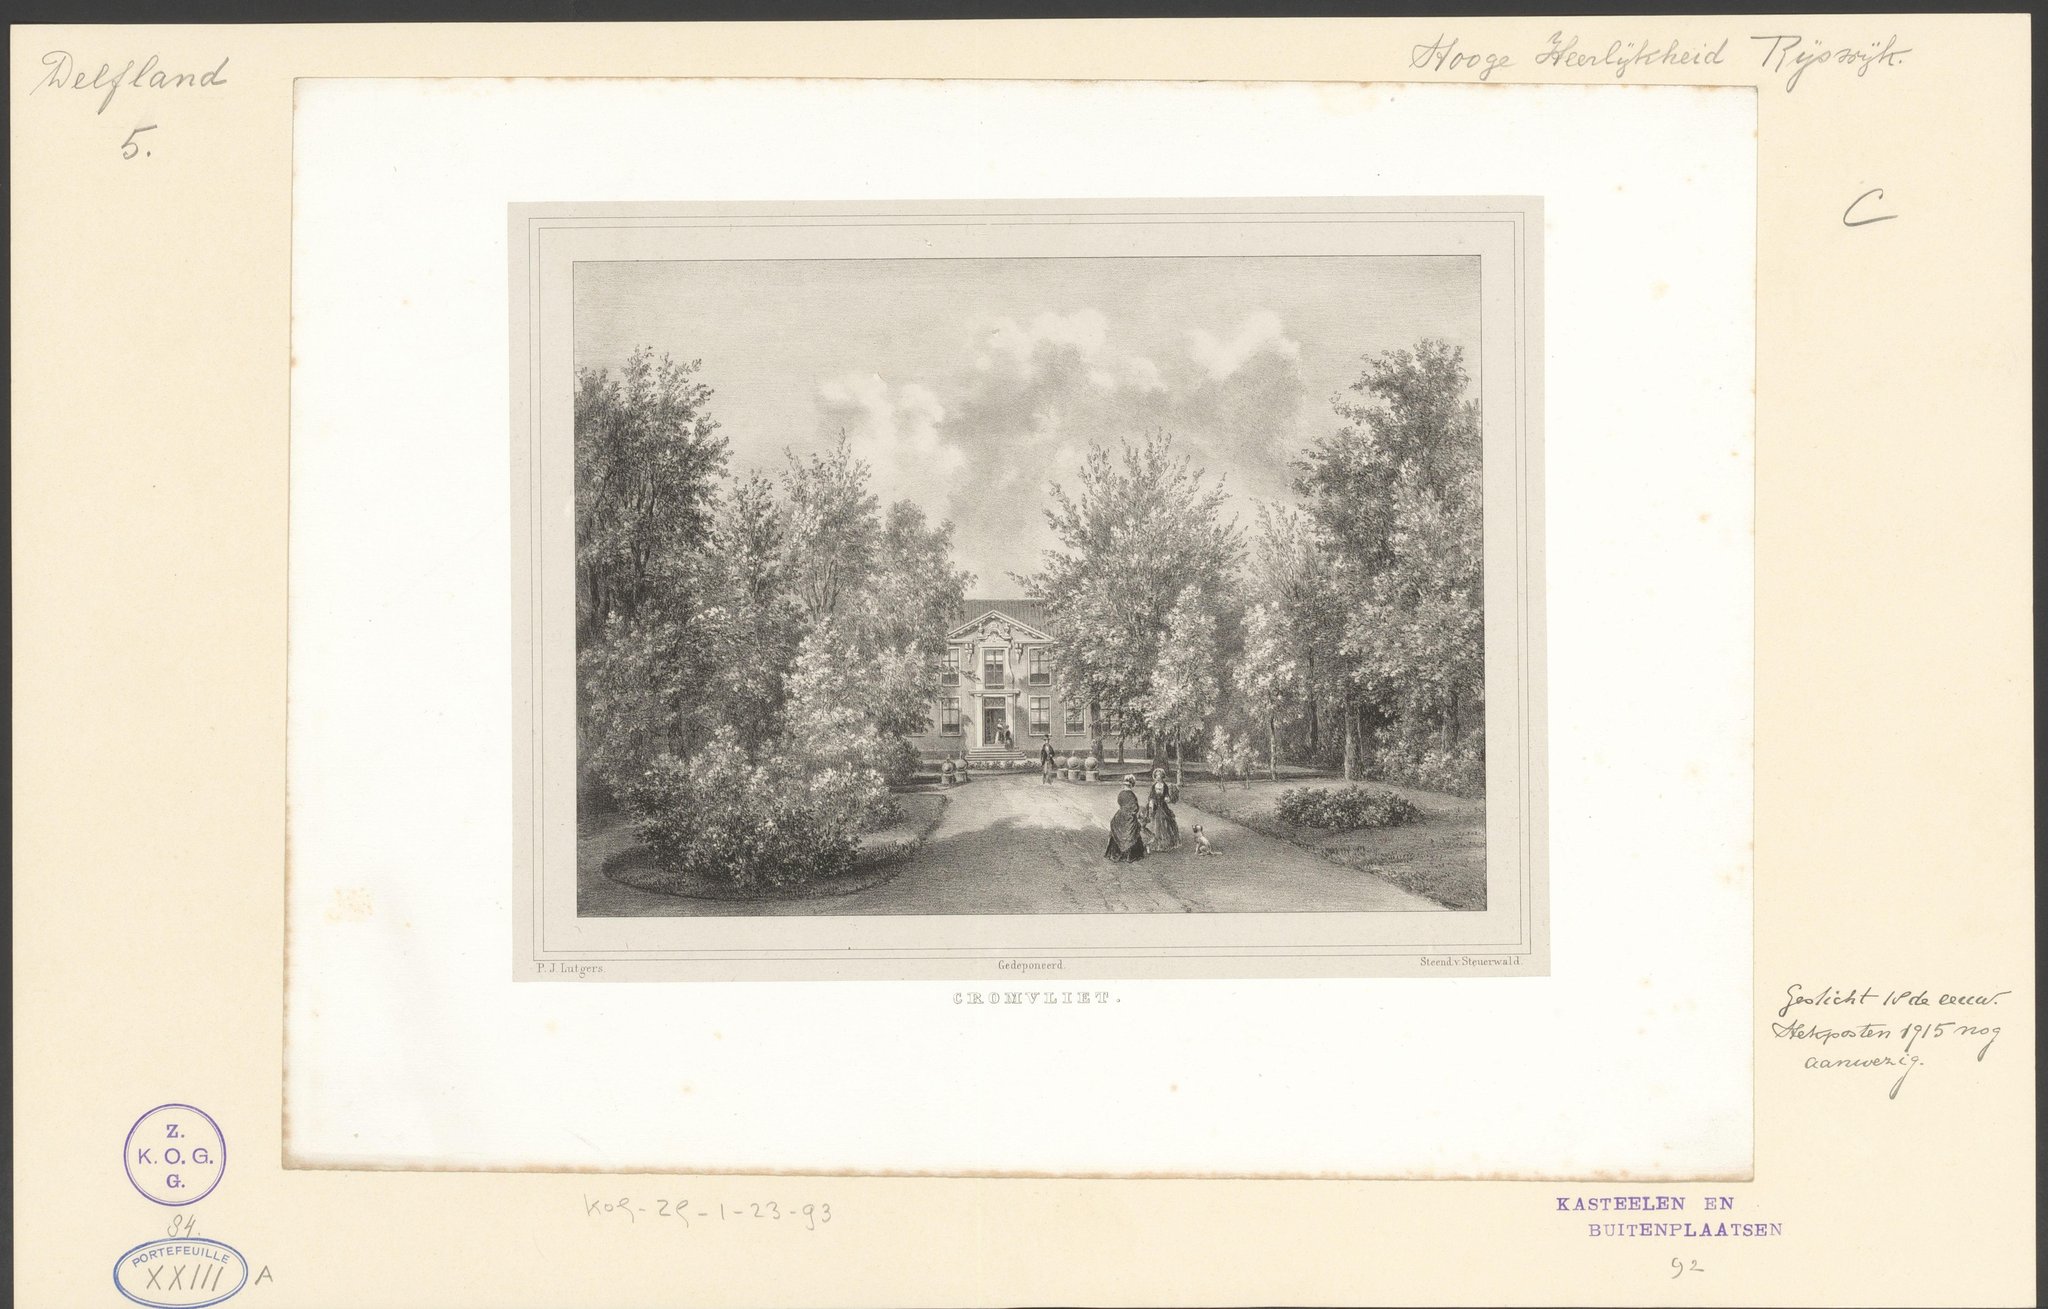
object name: print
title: Gezicht op de buitenplaats Cromvliet te Rijswijk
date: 1855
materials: paper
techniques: lithograph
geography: the hague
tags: trees, farm or solitary house in landscape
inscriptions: collector's mark: Lugt 1641, stamp, : ‘Gedeponeerd’, stamp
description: Onderwerpsrubrieken binnen de Atlas Zeden en Gewoonten: Zeden en Gewoonten in Engeren Zin, De Woning. Kastelen en buitenplaatsen. Holland (vervolg.)